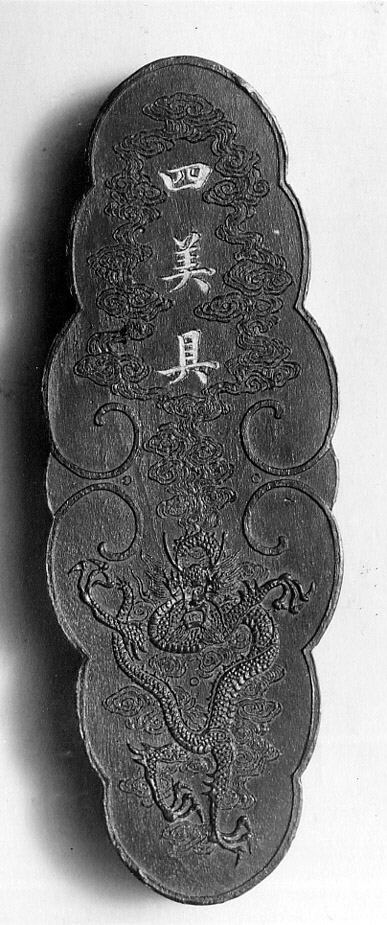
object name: ink tablet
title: Where all the Four Beauties are Present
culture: chinese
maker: jian guzhai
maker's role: artist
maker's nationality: chinese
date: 1867-1933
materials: ink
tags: dragons